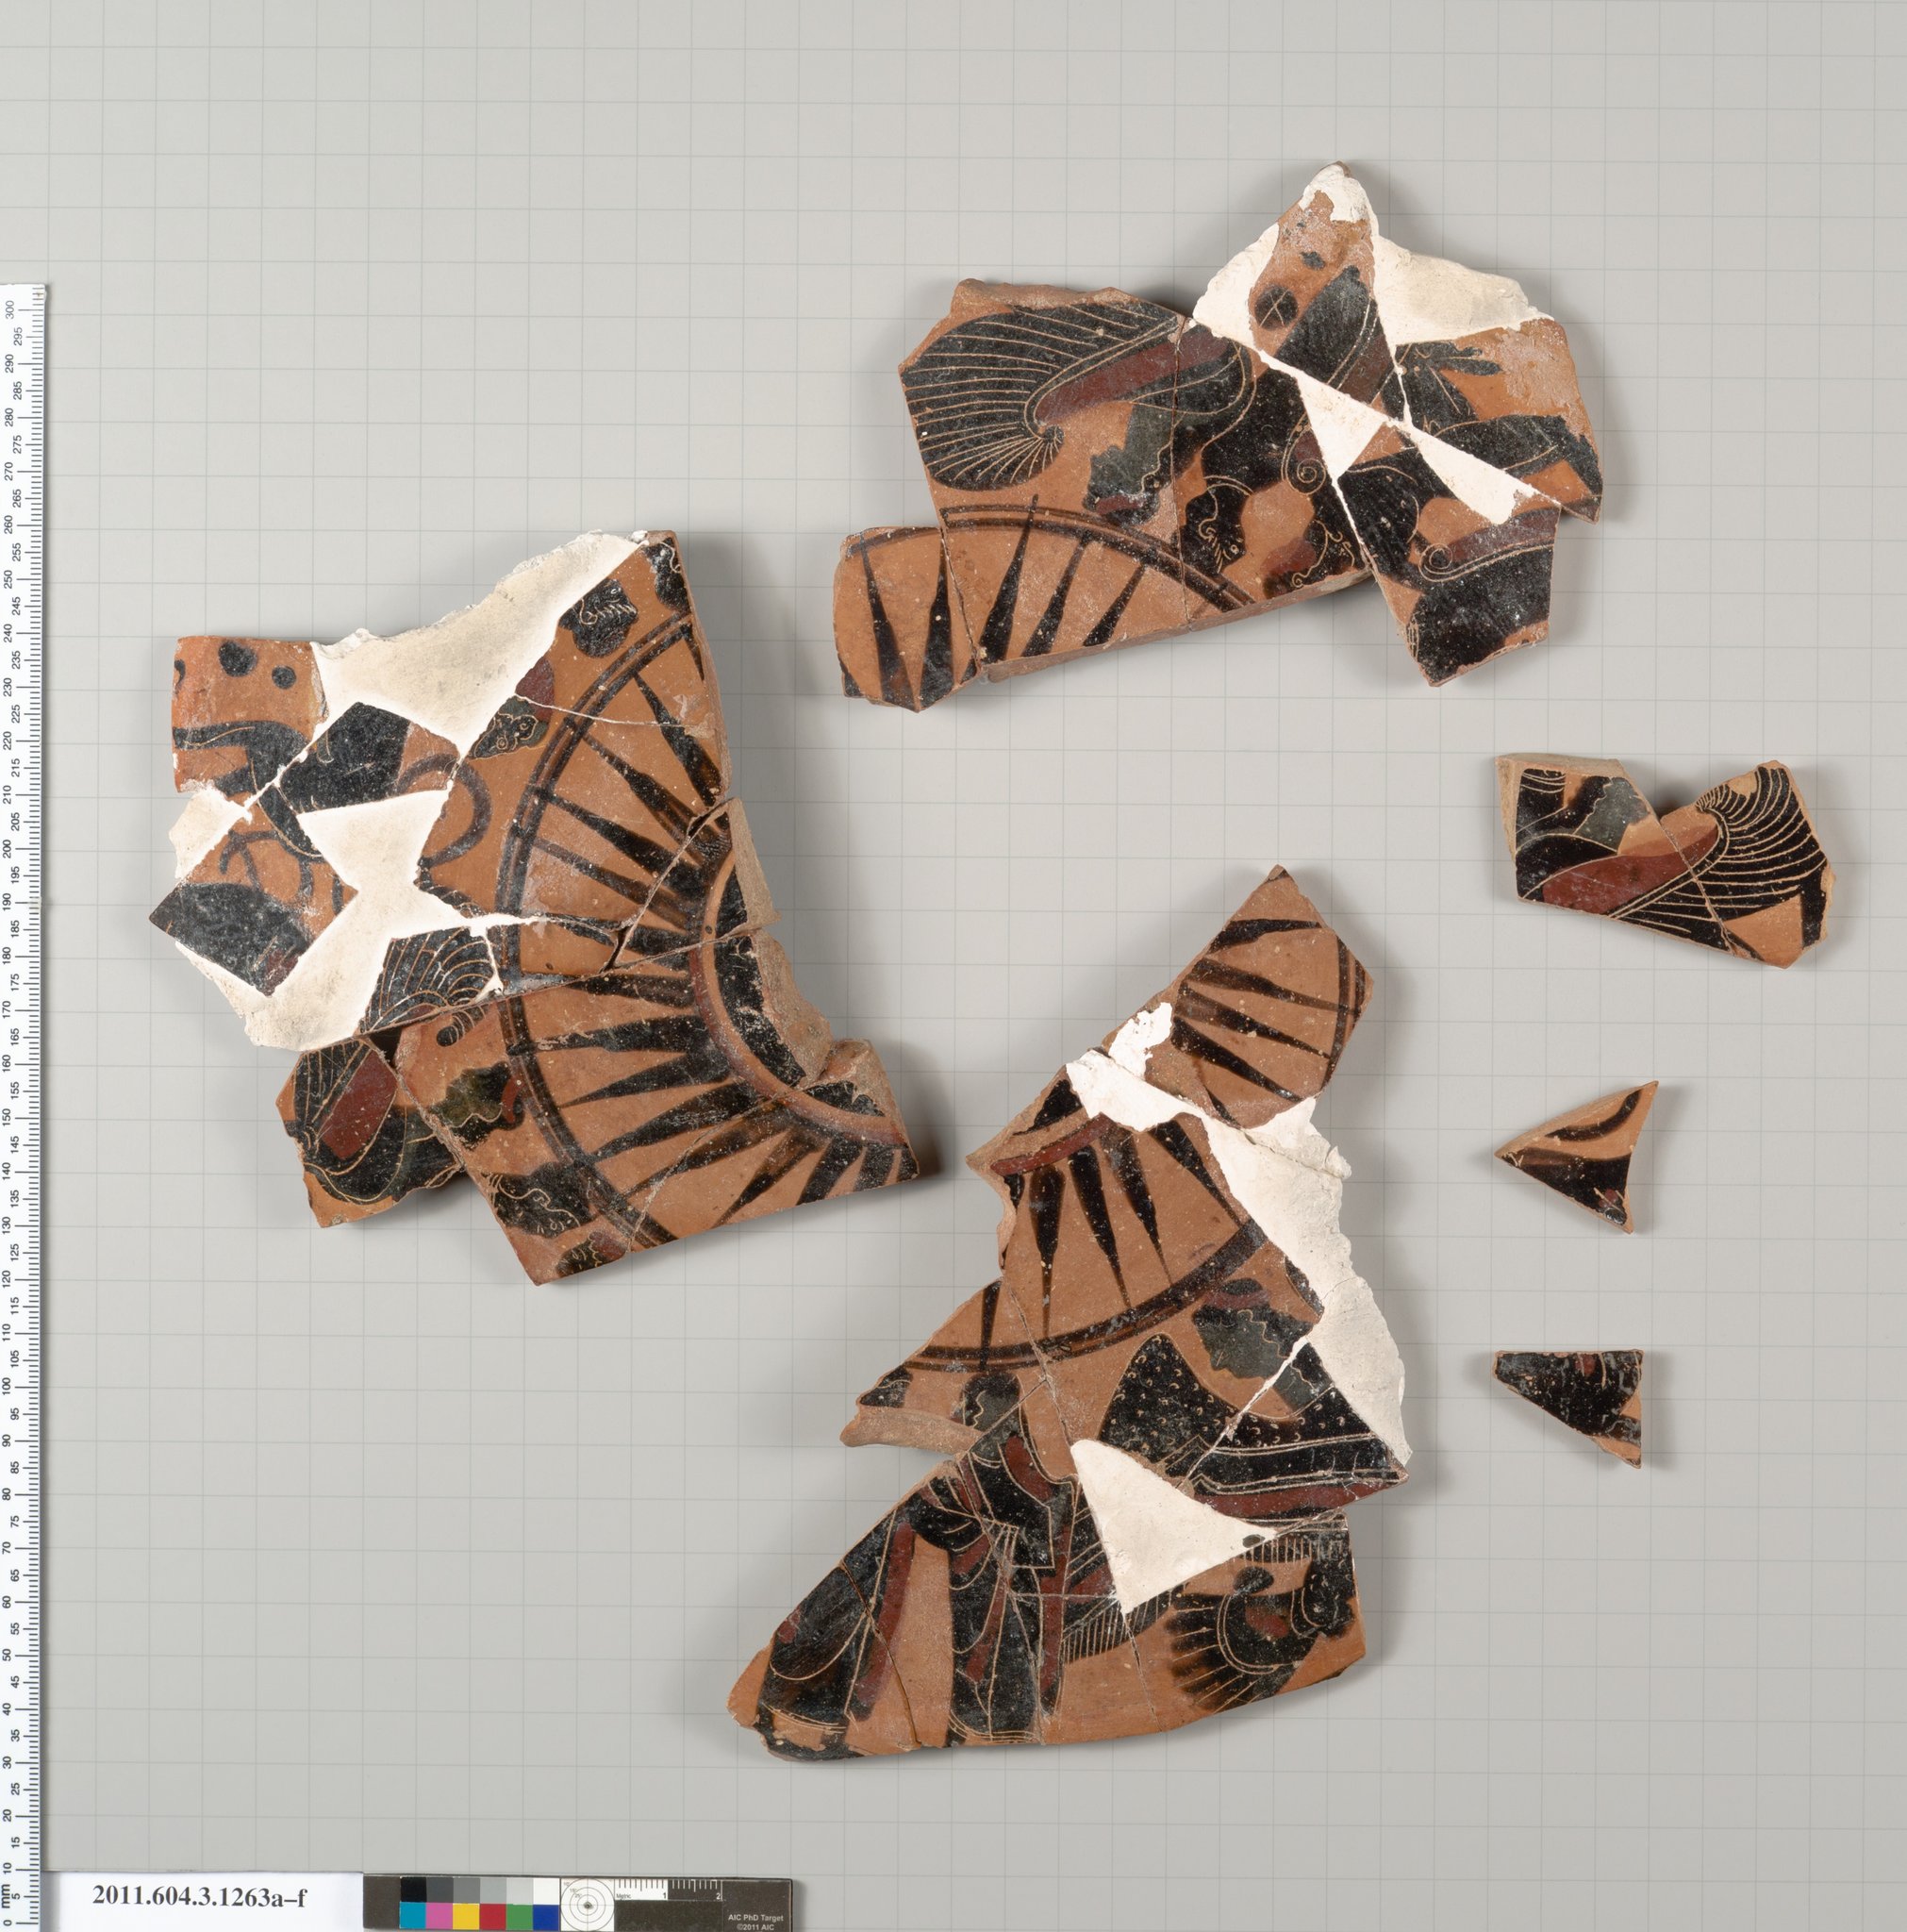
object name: lekanis lid fragment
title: Terracotta fragments of a lekanis lid (covered dish)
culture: greek, attic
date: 550-526 BCE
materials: terracotta